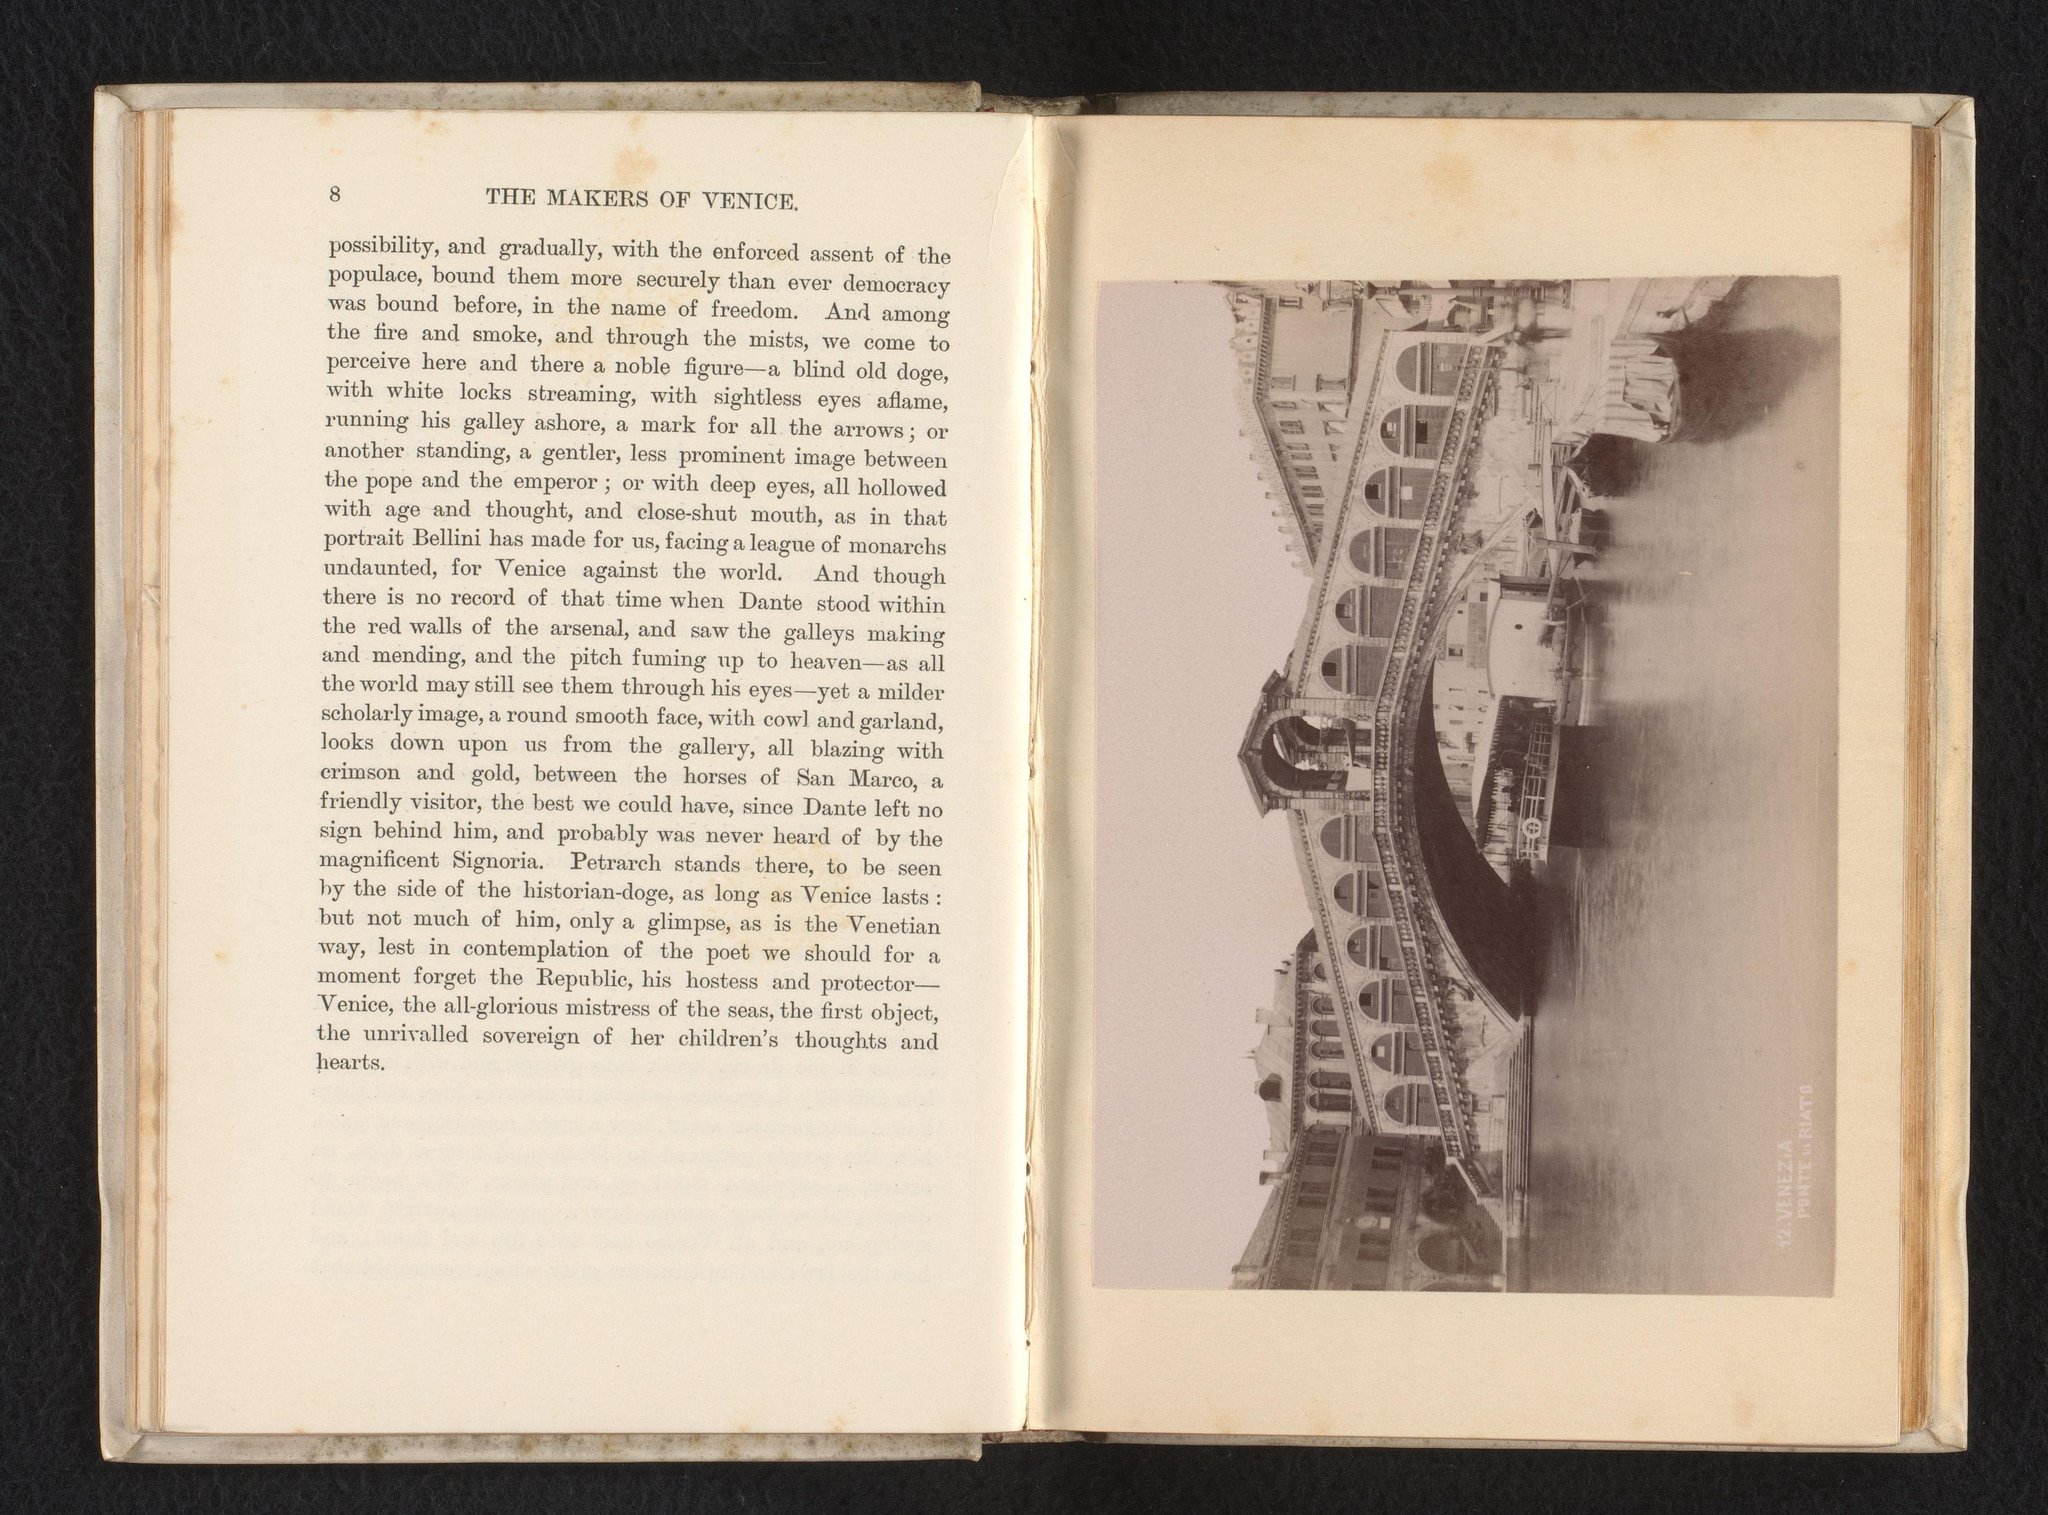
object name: photograph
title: Gezicht op de Rialtobrug in Venetië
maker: Anonymous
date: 1888-1893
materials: paper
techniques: albumen print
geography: venice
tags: bridge in city across river, canal, etc.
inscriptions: number: ‘12.’